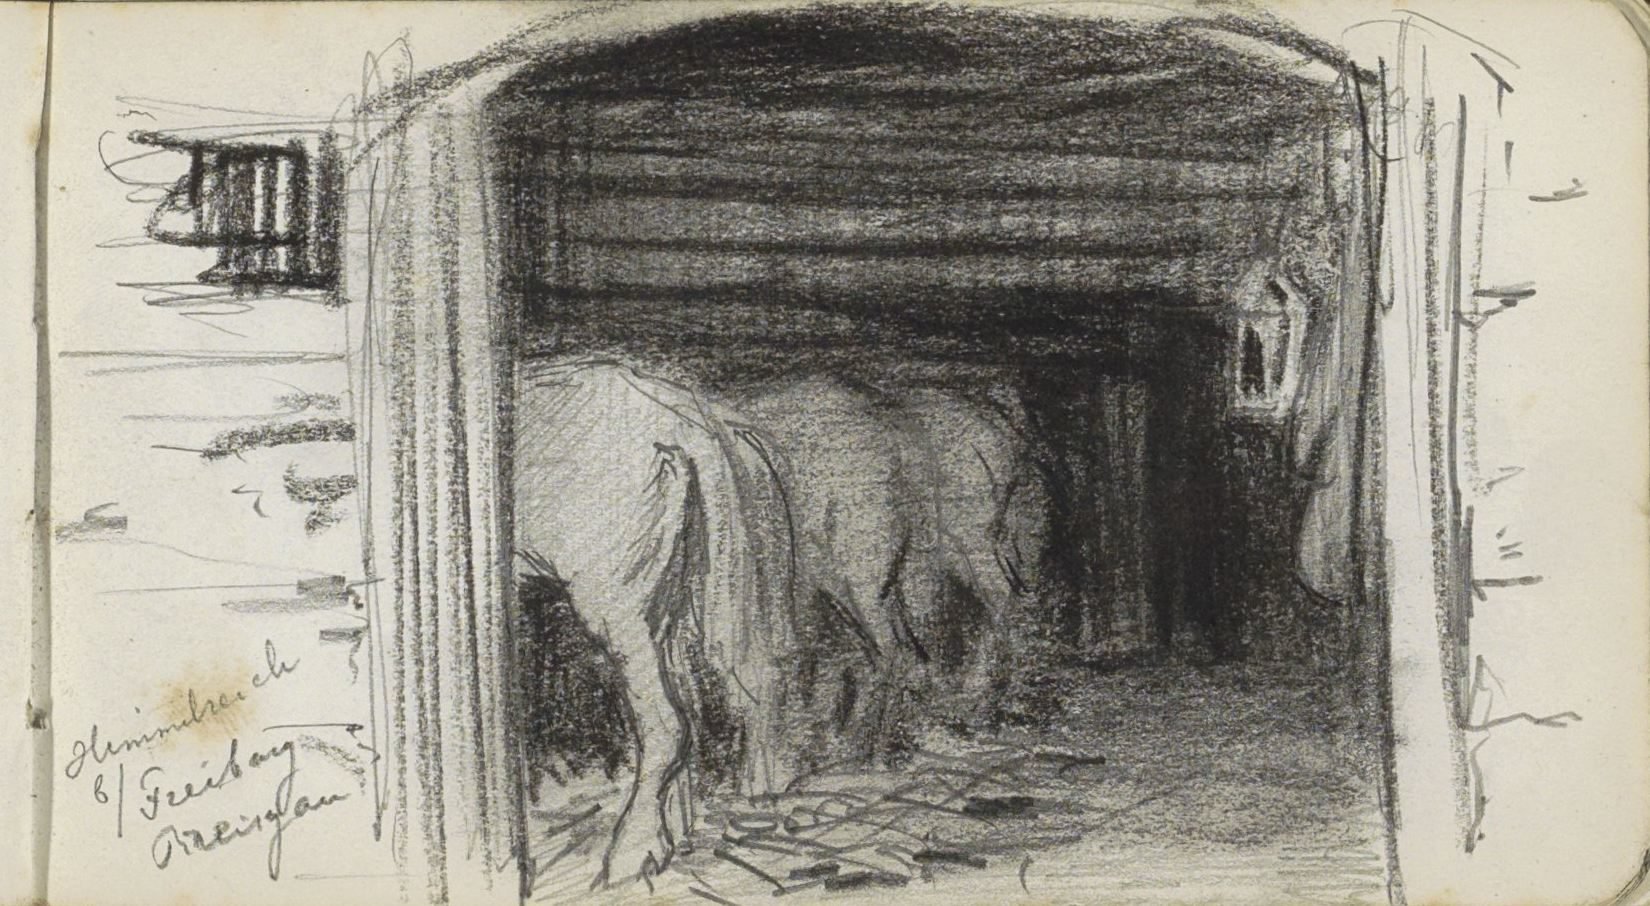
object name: sketchbook leaf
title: Paardenstal te Himmelreich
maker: geo poggenbeek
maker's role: draughtsman, painter, print maker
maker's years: 1853-1903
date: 1808-1876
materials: chalk, paper, pencil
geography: himmelreich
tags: horse, stall, stable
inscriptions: date and inscription: ‘Himmelreich/ 8/ Freiberg/ Breisgau’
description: Blad 47 recto uit een schetsboek met 69 bladen.